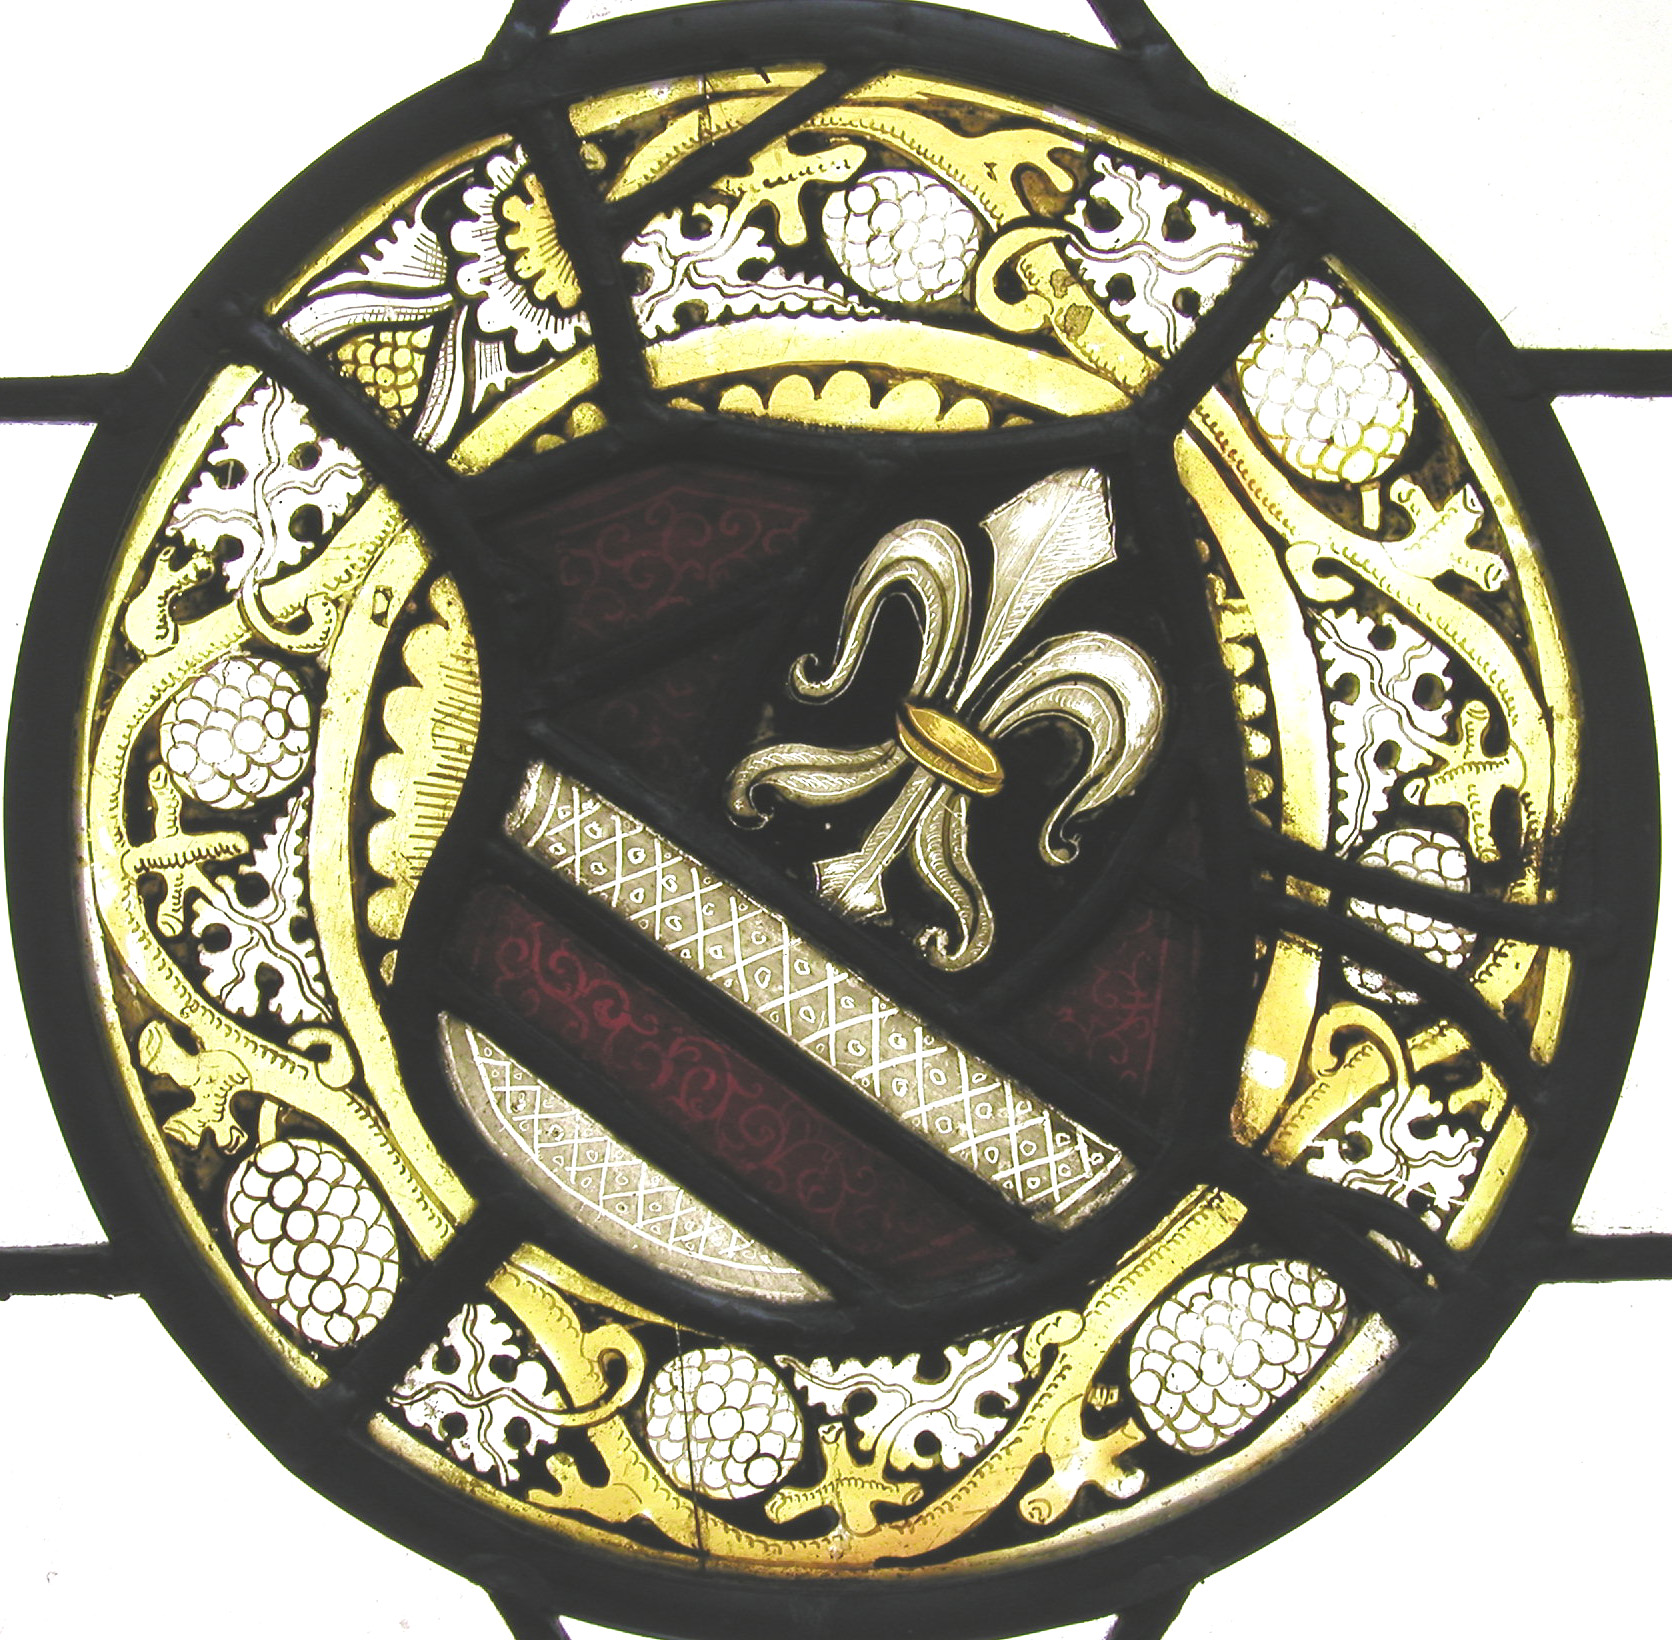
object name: roundel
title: Armorial Roundel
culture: german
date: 1500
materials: glass, metal, paint, pigment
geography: germany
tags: coat of arms